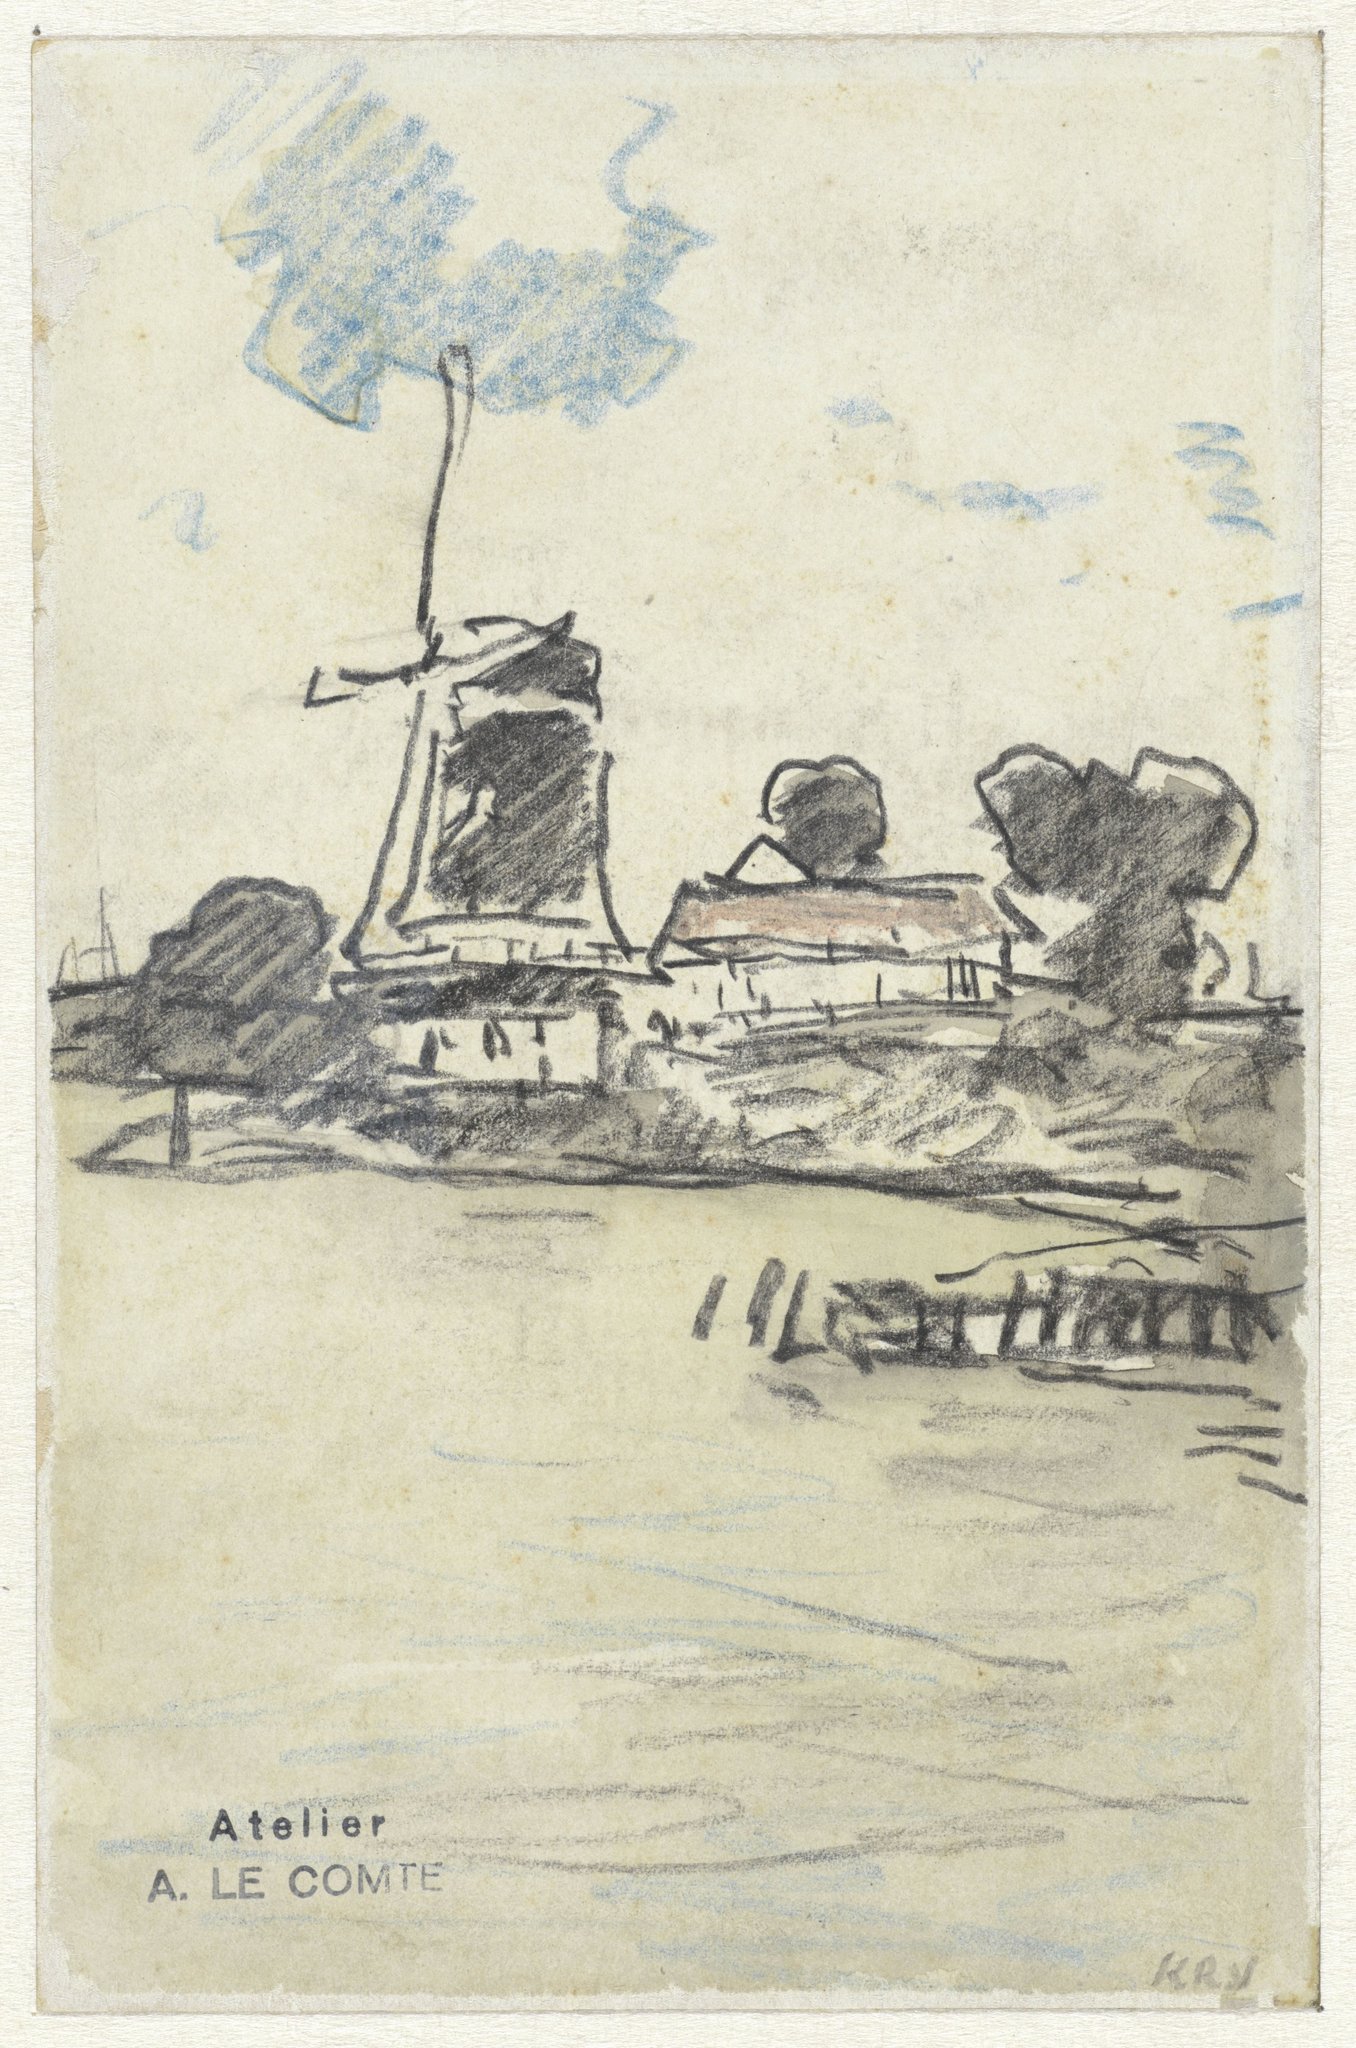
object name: drawing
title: Molen aan het water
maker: adolf le comte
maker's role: draughtsman, painter, print maker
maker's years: 1850-1921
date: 1860-1921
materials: chalk, paper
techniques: brush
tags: windmill